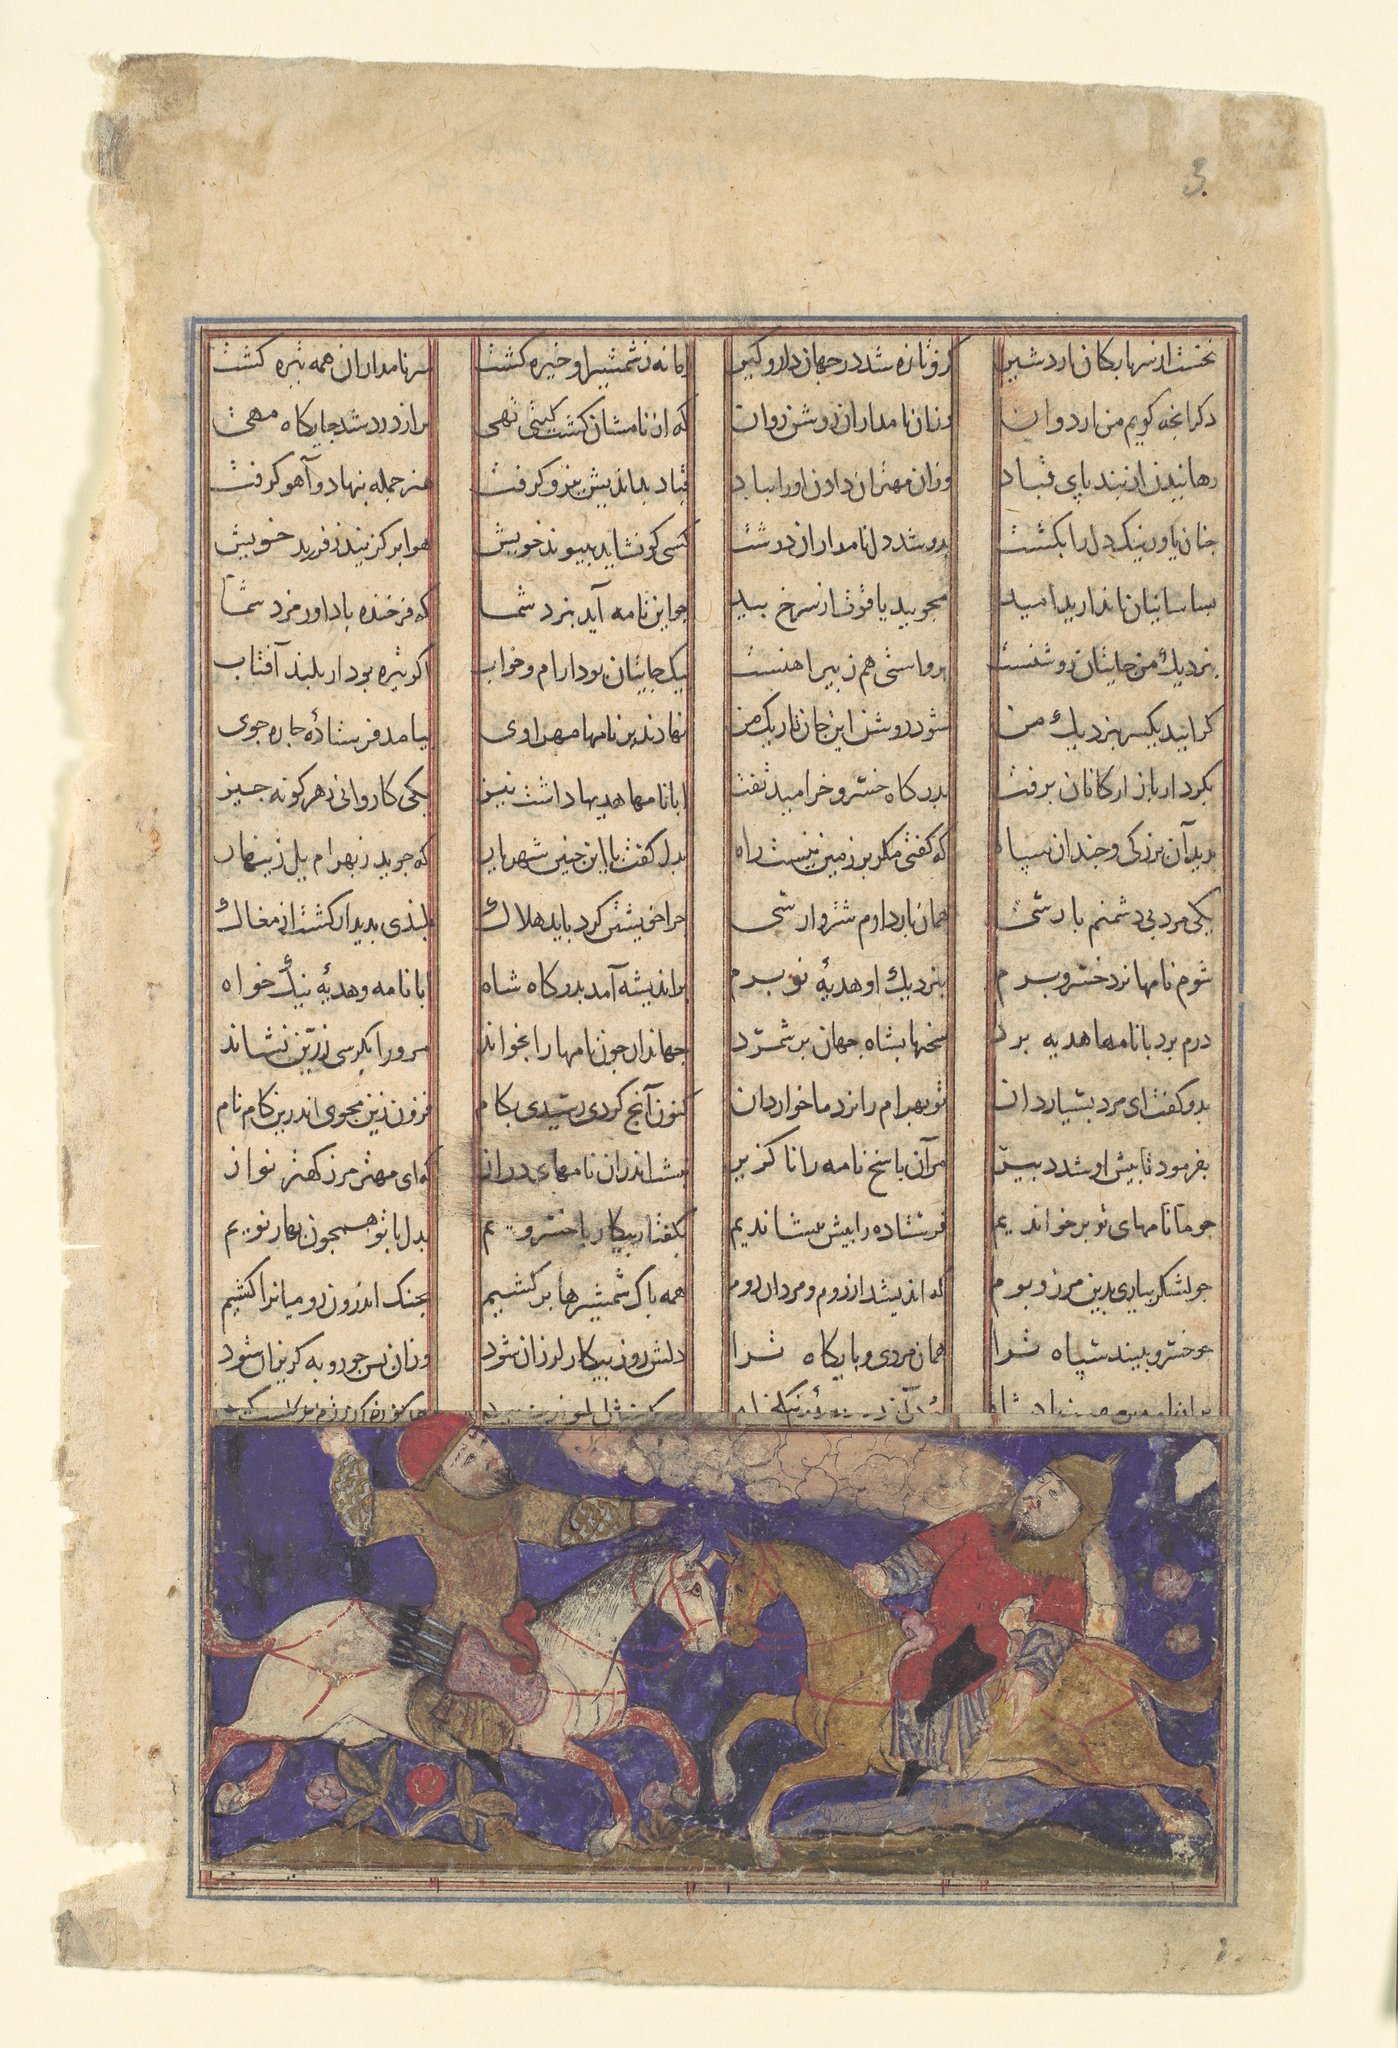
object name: folio from an illustrated manuscript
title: "The Combat of Khusrau Parviz and Bahram Chubina (?)", Folio from a Shahnama (Book of Kings)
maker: abu'l qasim firdausi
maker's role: author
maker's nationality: iranian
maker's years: 935-1020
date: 1330-1340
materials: gold, ink, paper, silver, watercolor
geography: iran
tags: poetry,men,horses